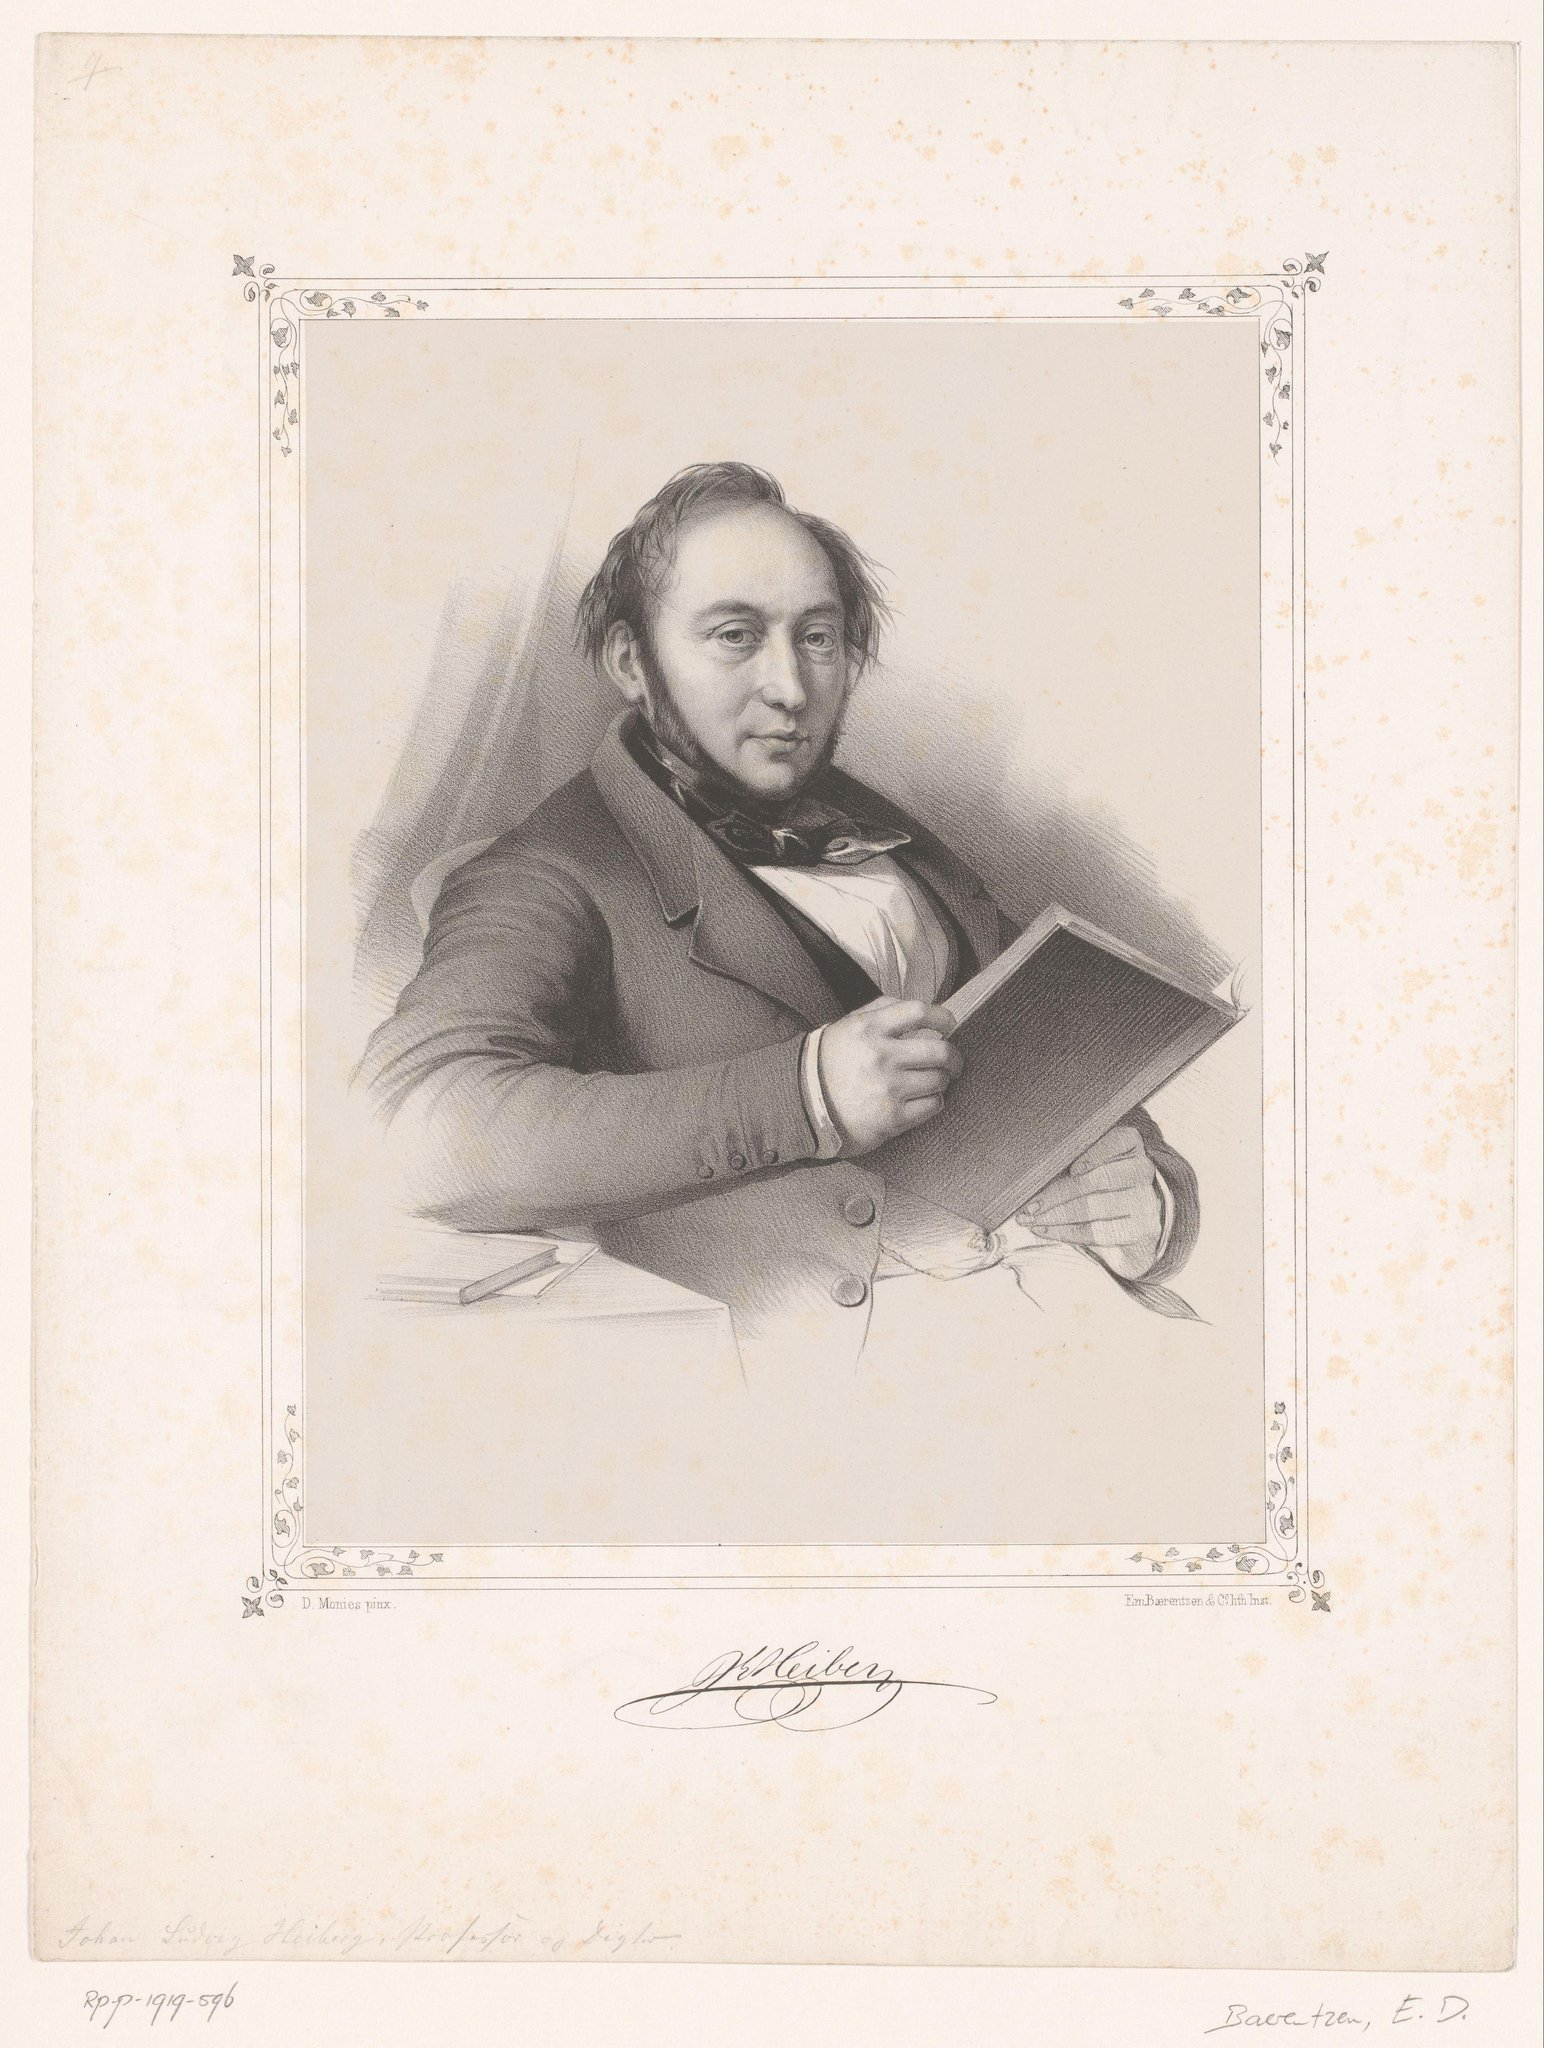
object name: print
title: Portret van Johan Ludvig Heiberg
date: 1837-1868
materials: paper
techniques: lithograph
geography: copenhagen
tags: historical persons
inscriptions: inscription: ‘JLHeiberg’, inscription: ‘D. Monies pinx.’, collector's mark: Lugt 2228, inscription: ‘Em. Baerentzen & Co lith.Inst.’